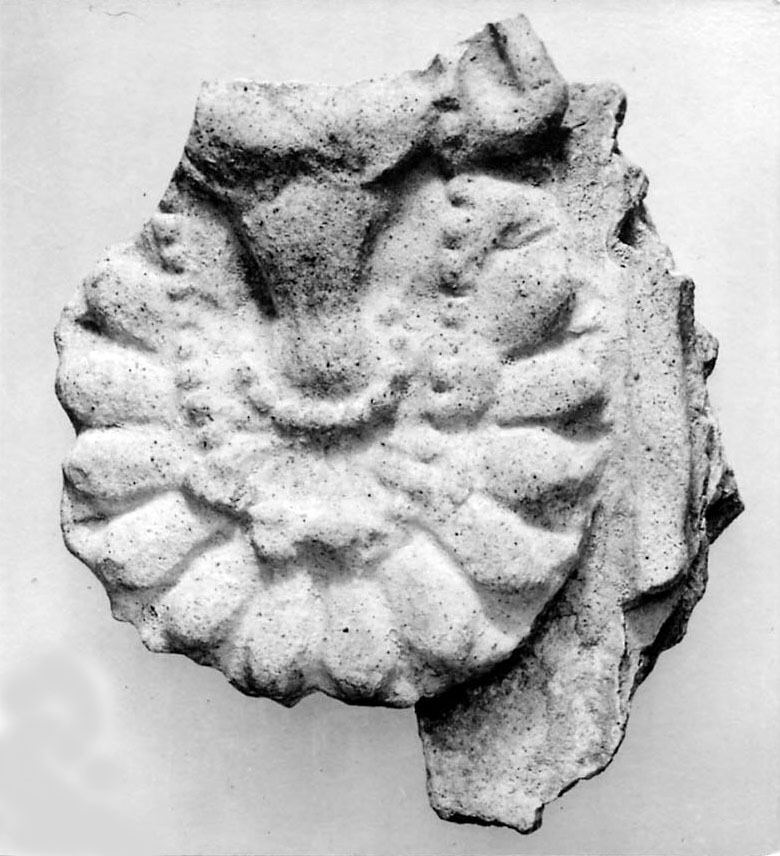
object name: relief fragment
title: Fragment of a Relief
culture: central asian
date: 701-800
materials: plaster